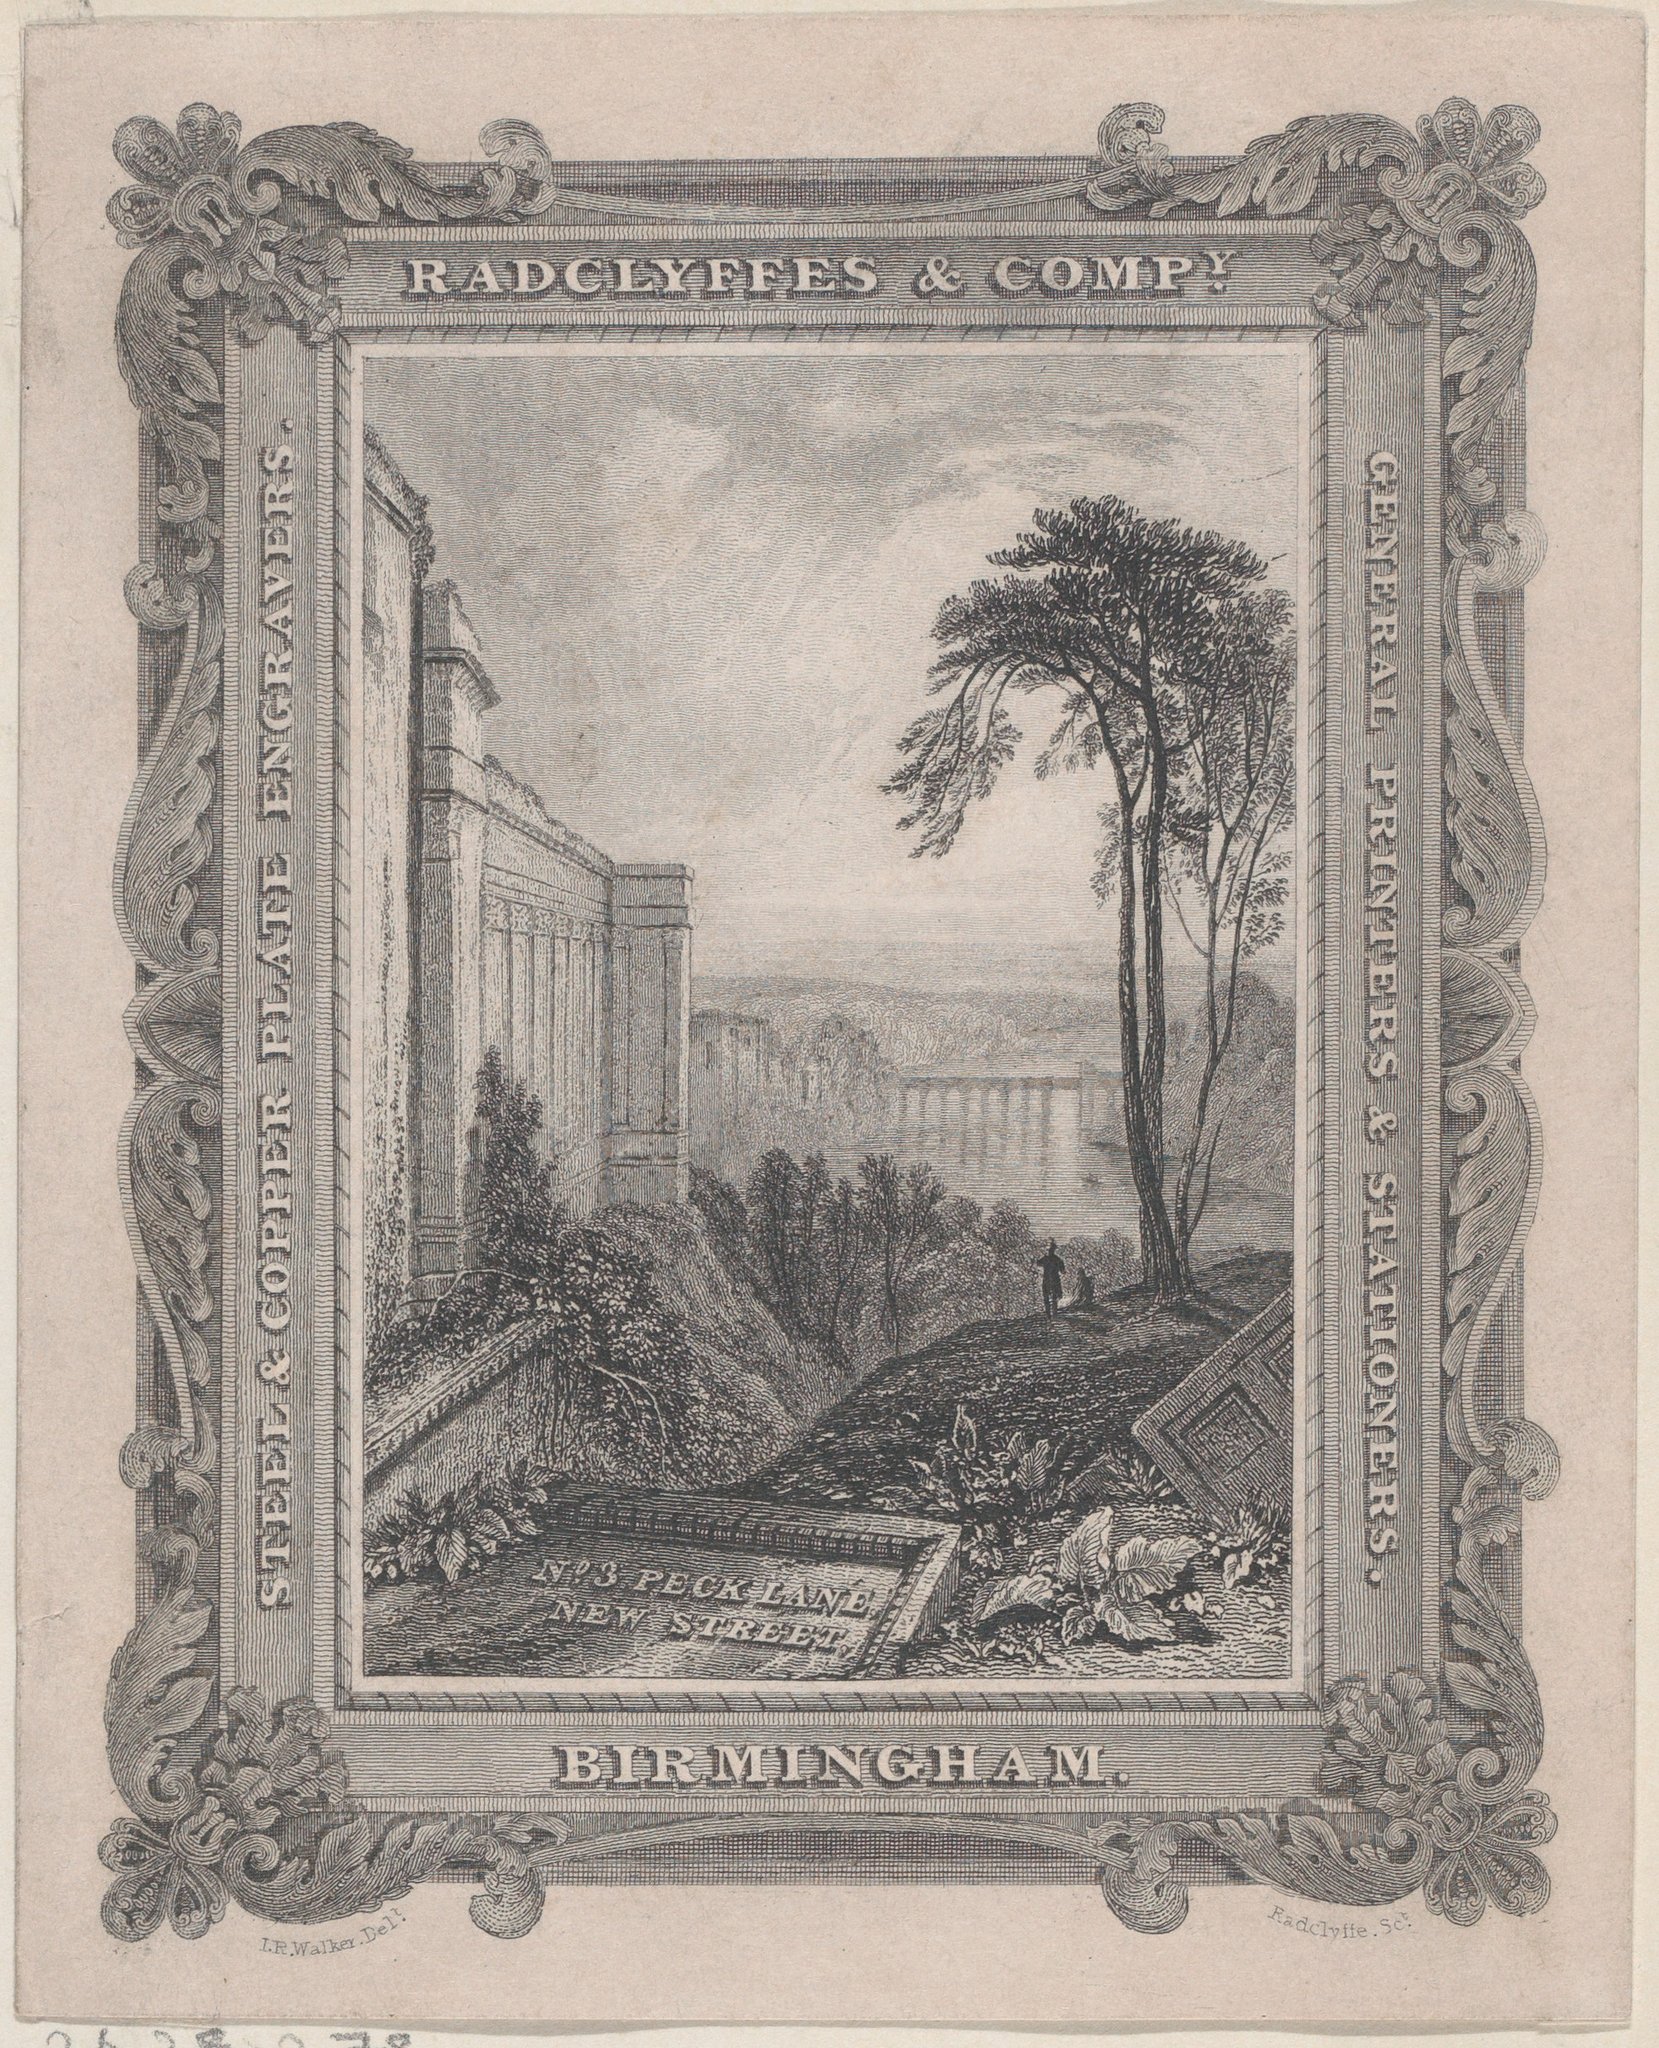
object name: print, trade card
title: Trade Card for Radclyffe & Co., Steel & Copper Plate Engravers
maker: anonymous, british, 19th century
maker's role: artist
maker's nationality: british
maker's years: 1800-1900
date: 1801-1900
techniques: engraving